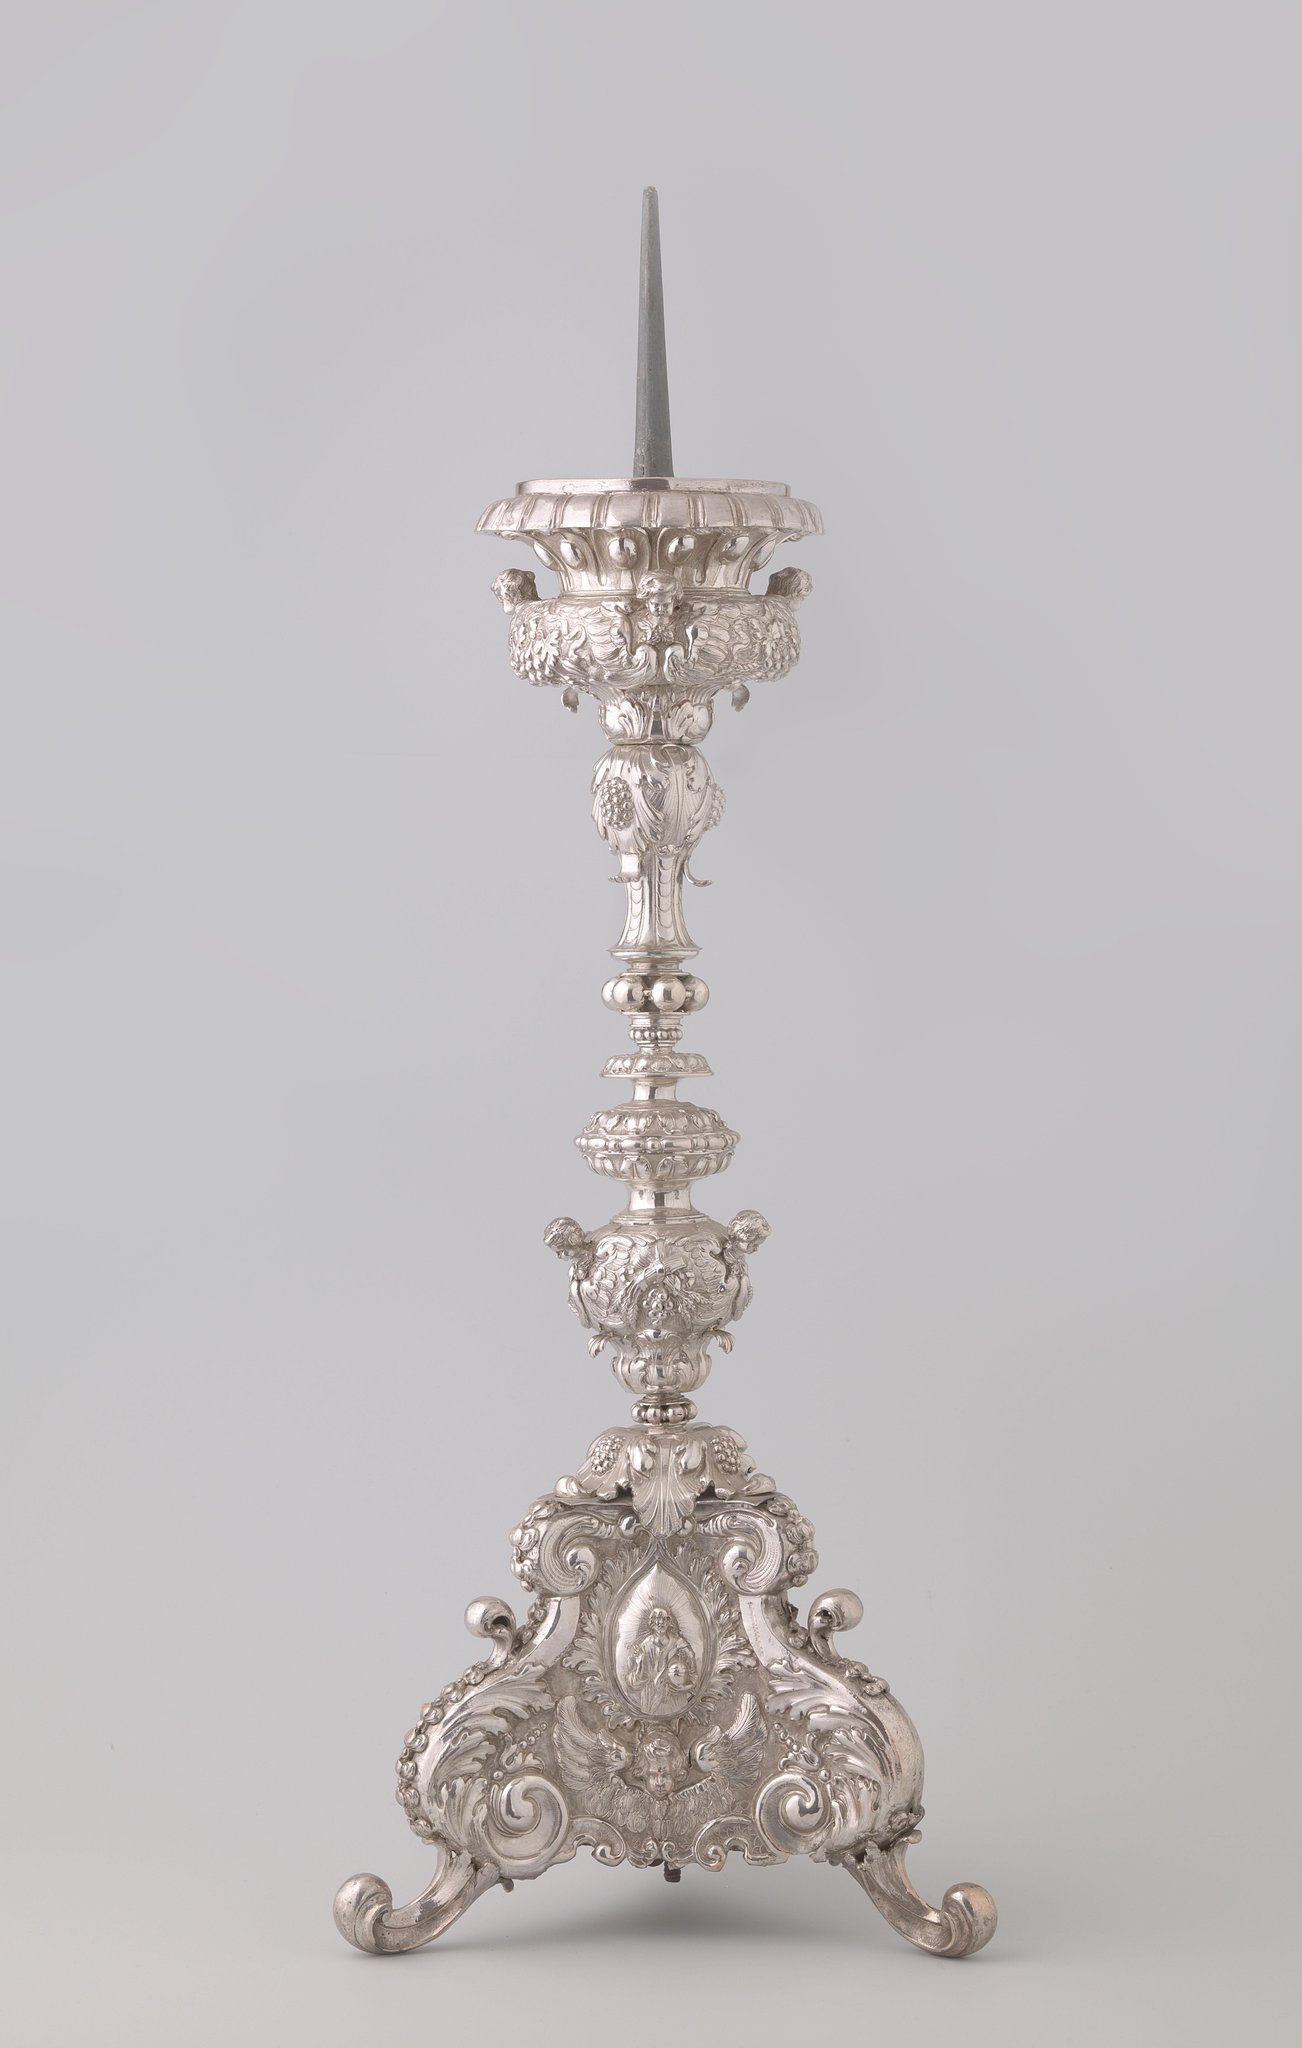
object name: candlestick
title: Kandelaar van zilver met vijfdelig gelede balusterstam op driehoekige voet op voluutpoten. Versierd met drie medaillons met Christus, Petrus en Ignatius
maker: jos hannekin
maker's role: silversmith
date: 1701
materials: silver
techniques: gilding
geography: antwerp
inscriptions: mark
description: Six altar candlesticks. Silver. Antwerp, 1701, by Jos Hannekin.